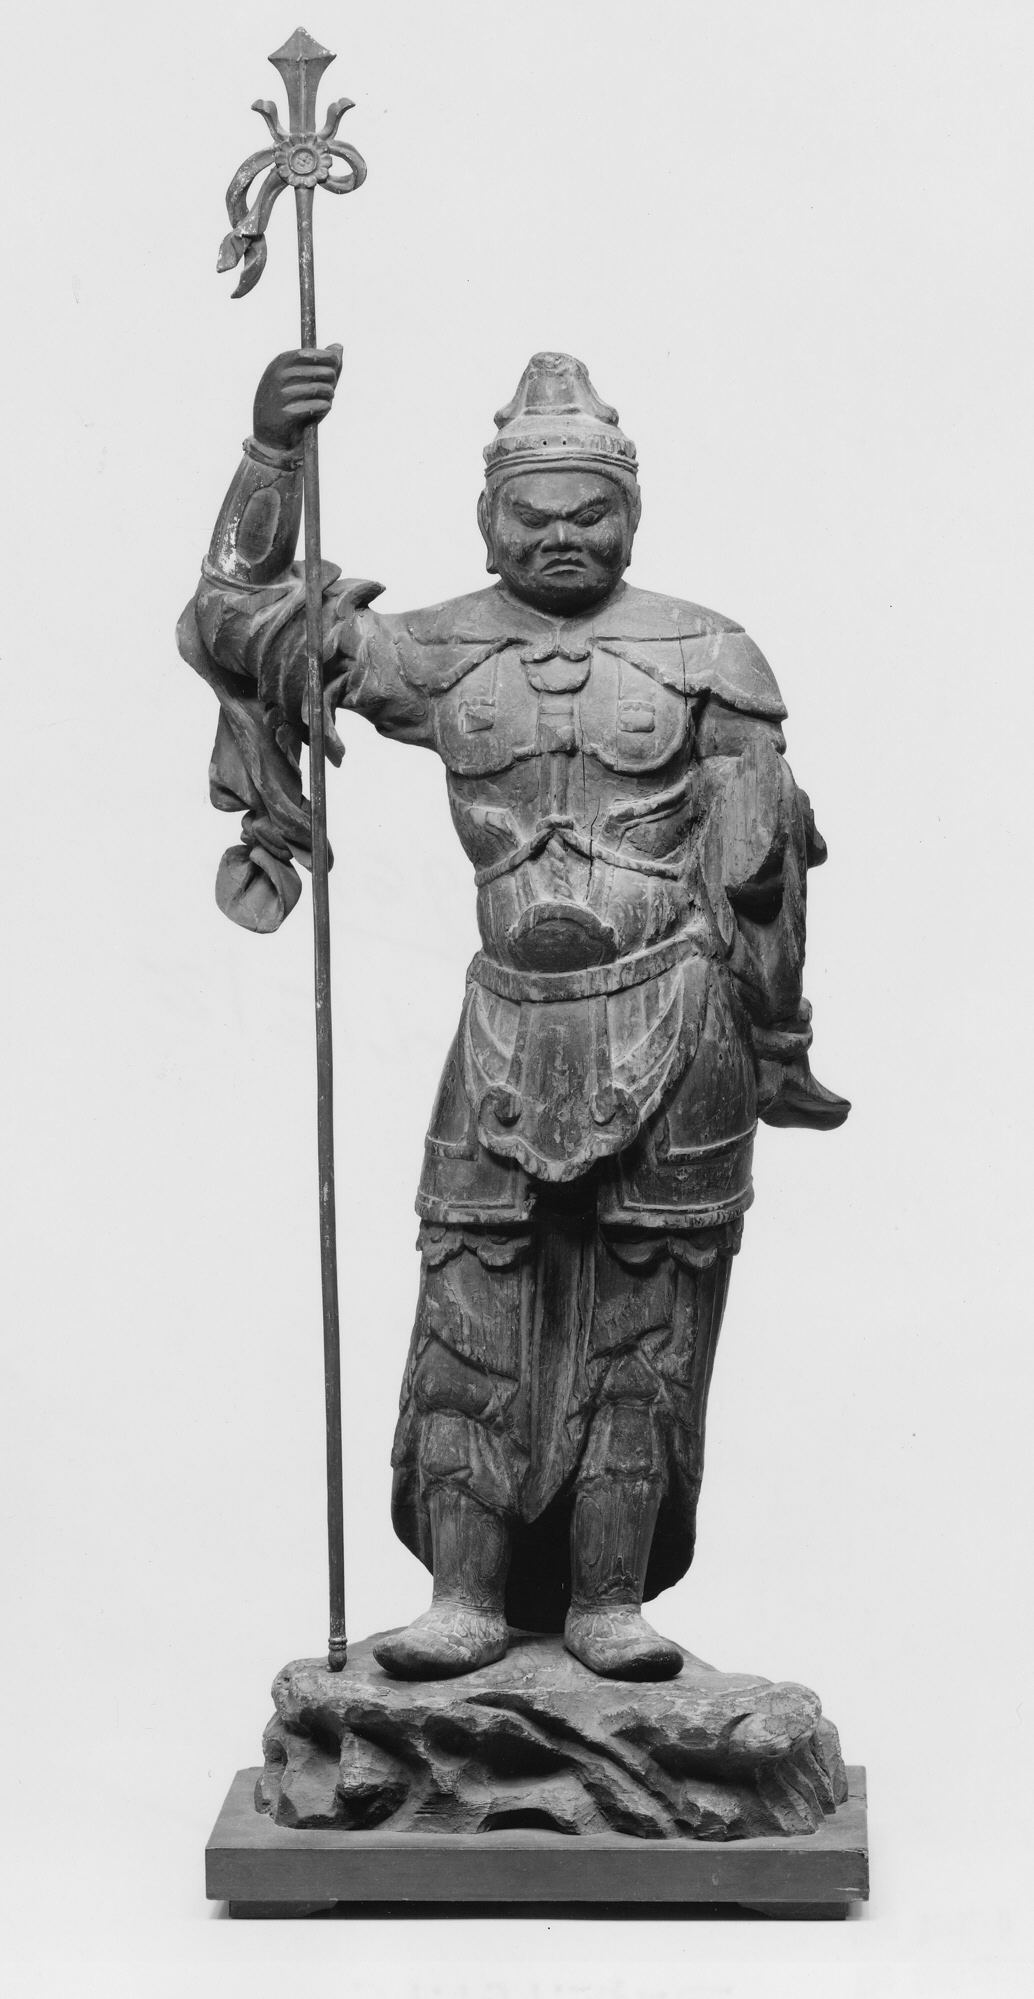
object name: figure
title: The Guardian King Bishamonten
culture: japanese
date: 1101-1200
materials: gold leaf, lacquer, wood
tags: kings,buddhism